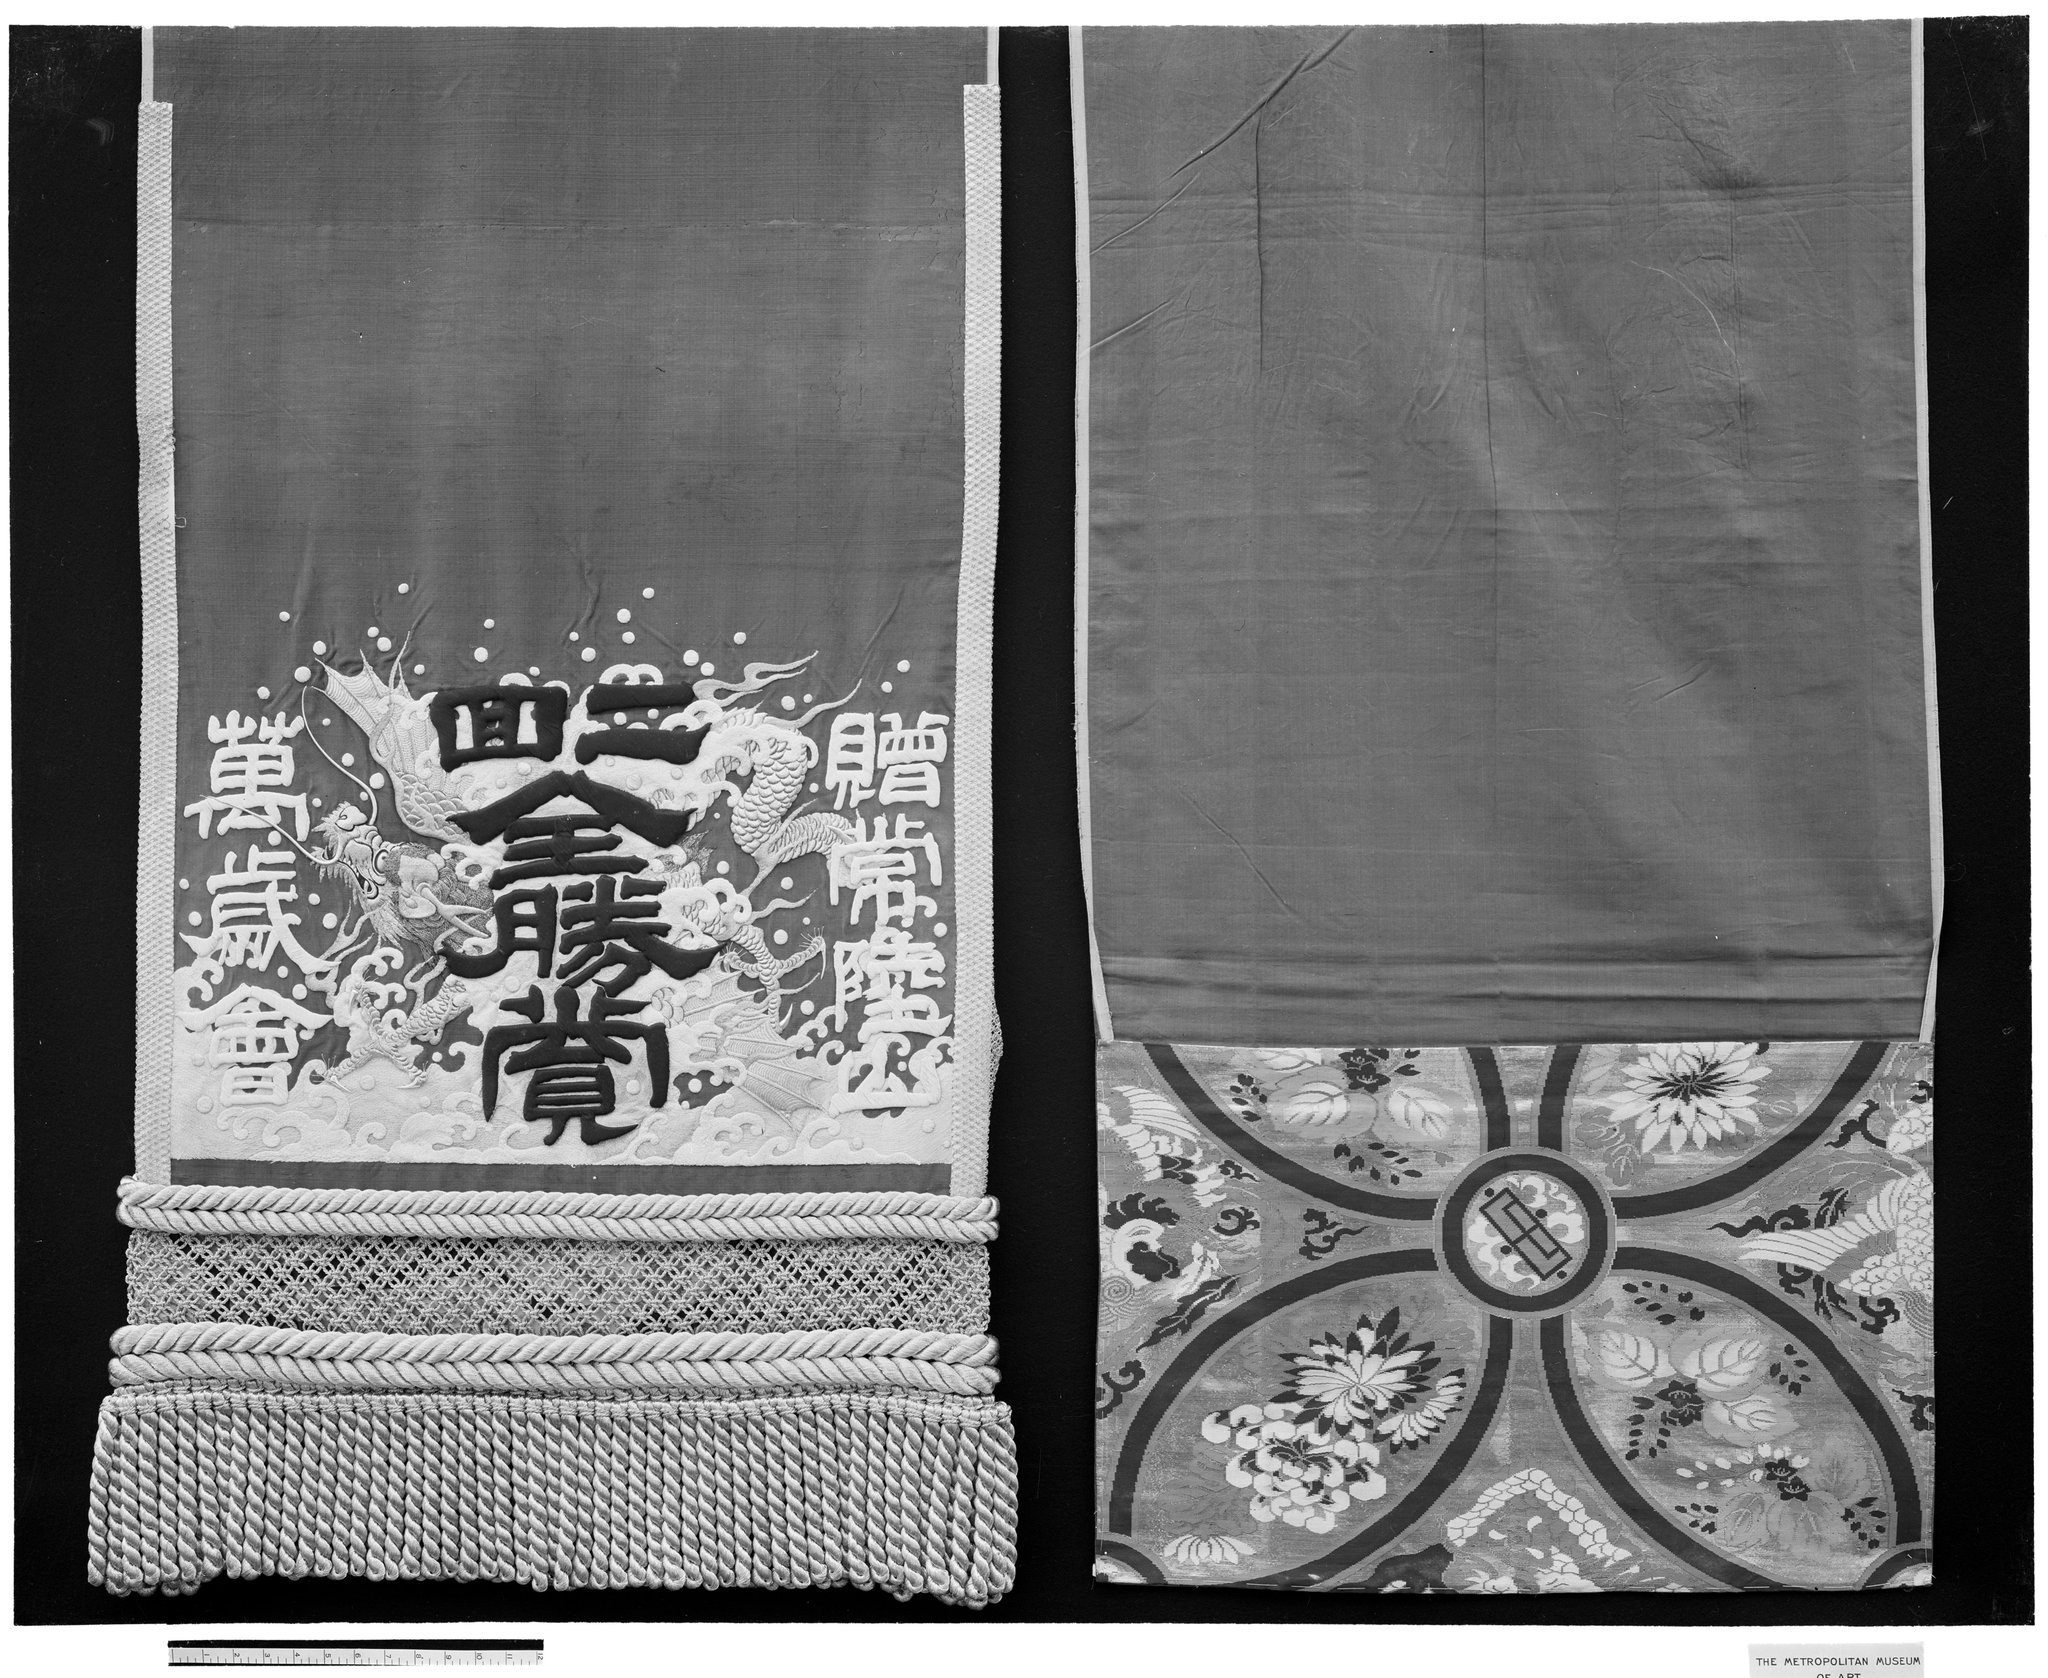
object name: wrestling costume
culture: japanese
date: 1801-1900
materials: gold, silk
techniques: embroidery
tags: dragons,flowers